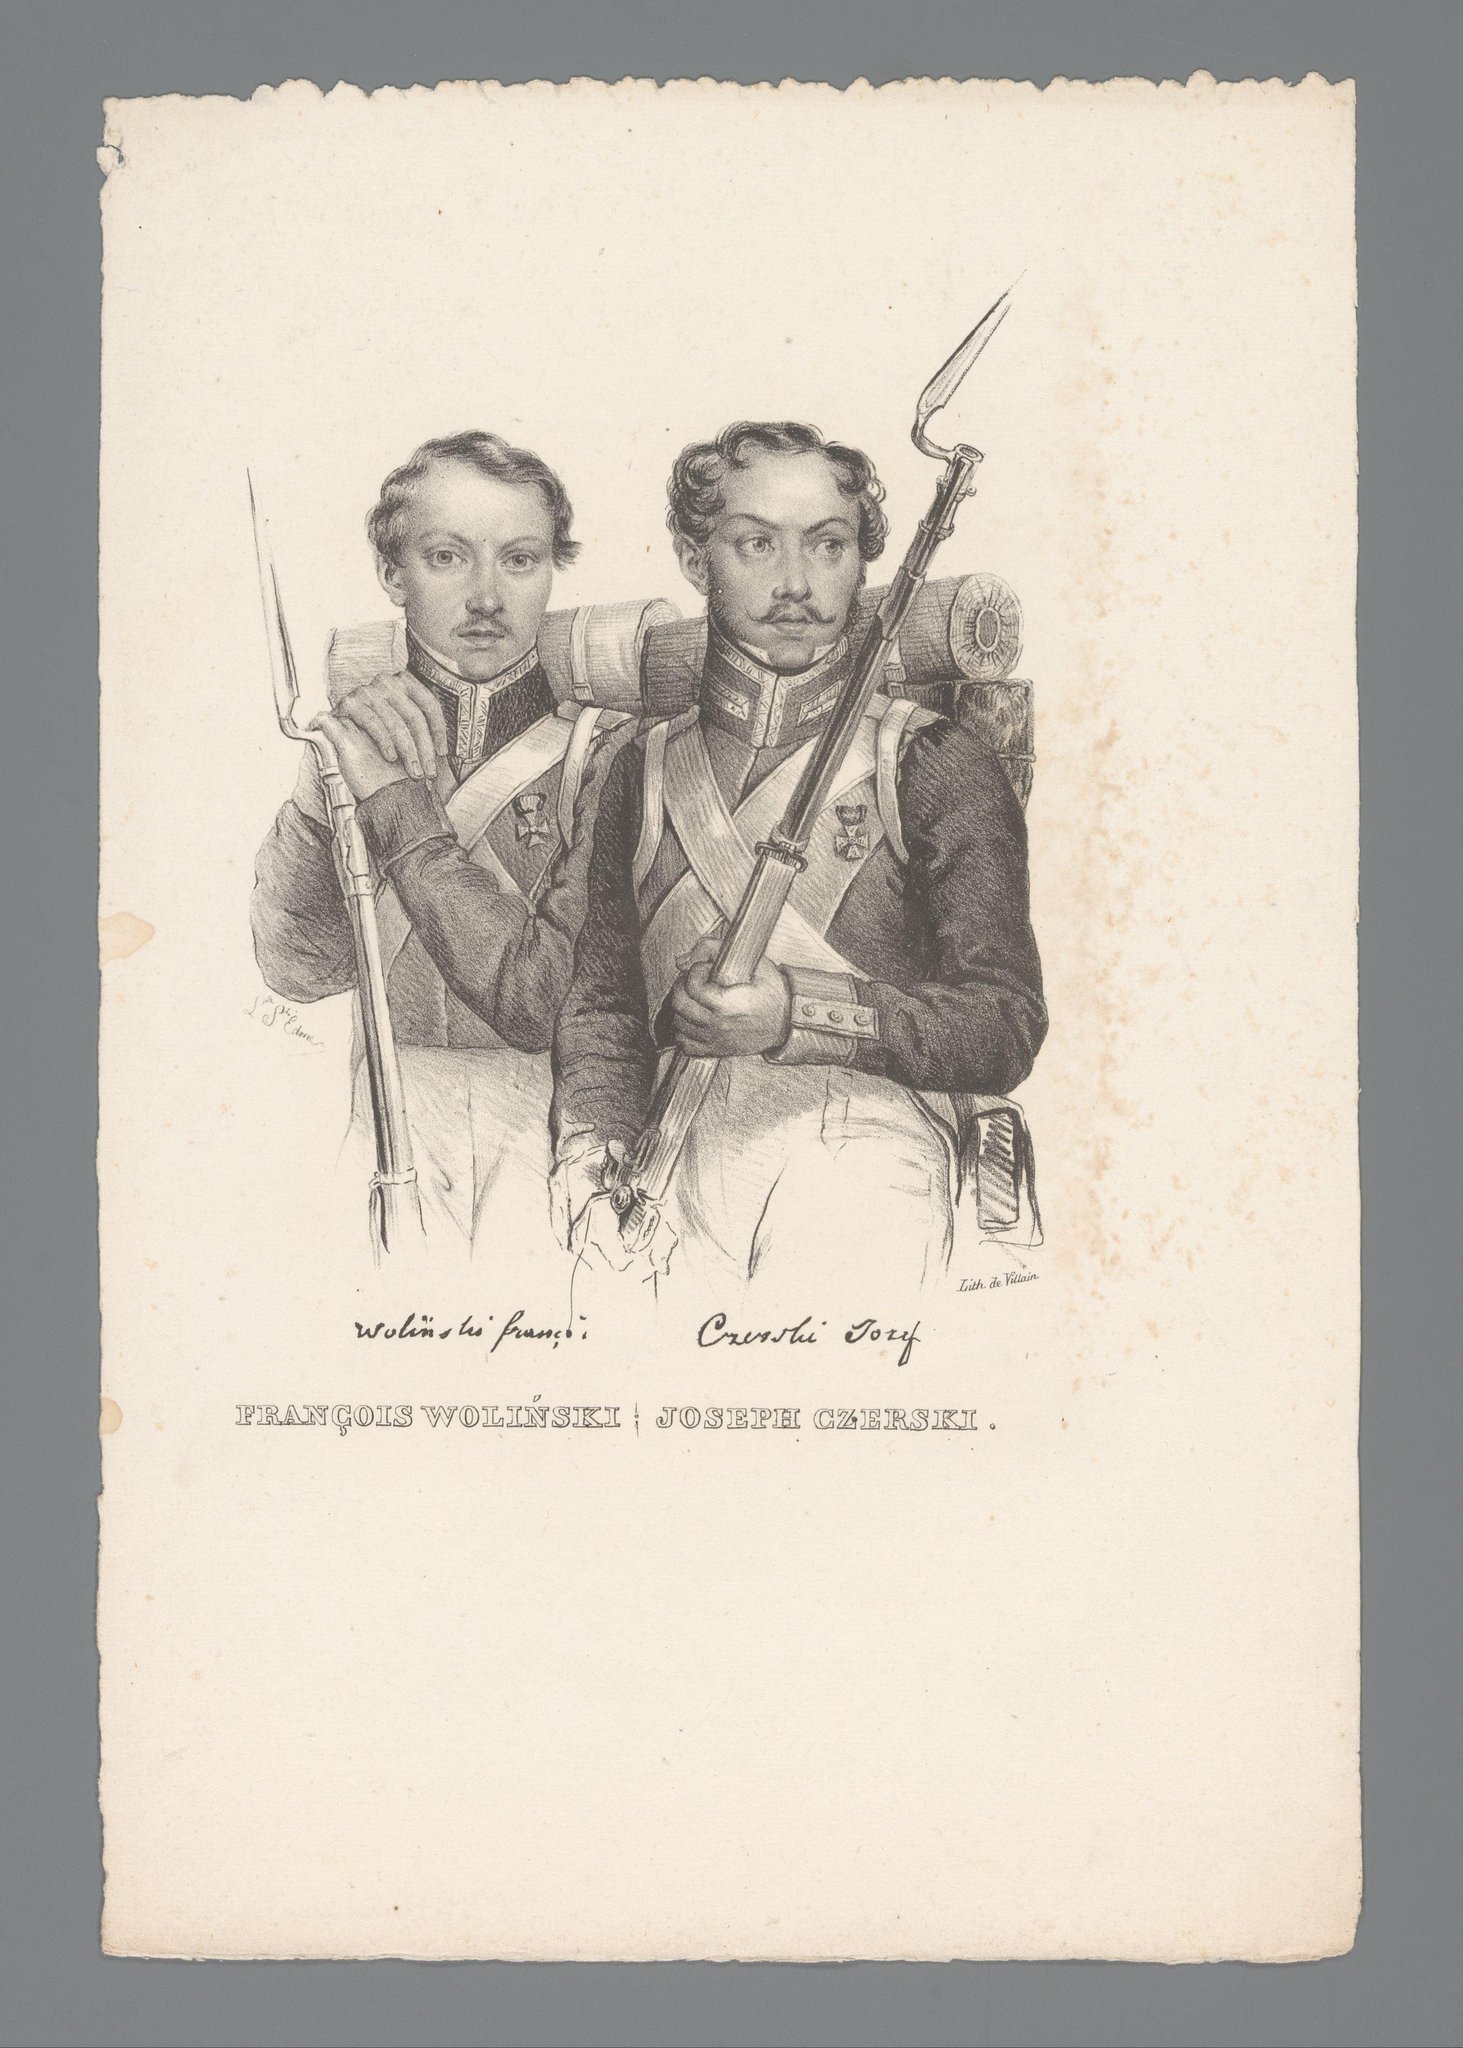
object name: book illustration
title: François Woliński, Joseph Czerski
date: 1832-1839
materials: paper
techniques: lithograph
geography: paris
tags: publisher, franciszek ksawery woliński, historical persons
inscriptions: collector's mark: Lugt 2228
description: Prent uit: Straszewicz., Joseph. Les polonais et les polonaises de la révolution du 29 novembre 1830, ou Portraits des personnes qui ont figuré dans la dernière guerre de l'indépendance polonaise, avec les fac-simile de leur signature, lithographiés sur dessins originaux, par les artistes les plus distingués: MM. Grévedon, Maurin, Vigneron, Belliard, Devéria, Bazin, Desmadryl, Lecler, Desmaisons, Rutowski, officier polonais, etc,. etc., accompagnés d'une biographie pour chaque portrait. Parijs: Catherine-Anaïs Pinard, 1832. Of uit: Straszewicz., Joseph. Les polonais et les polonaises de la révolution du 29 novembre 1830. Biographie des personnes qui ont figuré dans la dernière guerre de l'indépendance polonaise, avec les fac-simile de leur signature, ornée de 30 portraits lithographiés sur dessins originaux, par les artistes les plus distingués: MM. Grévedon, Maurin, Vigneron, Belliard, Devéria, Bazin, Desmadryl, Lecler, etc., etc.. Parijs: s.n., 1839.